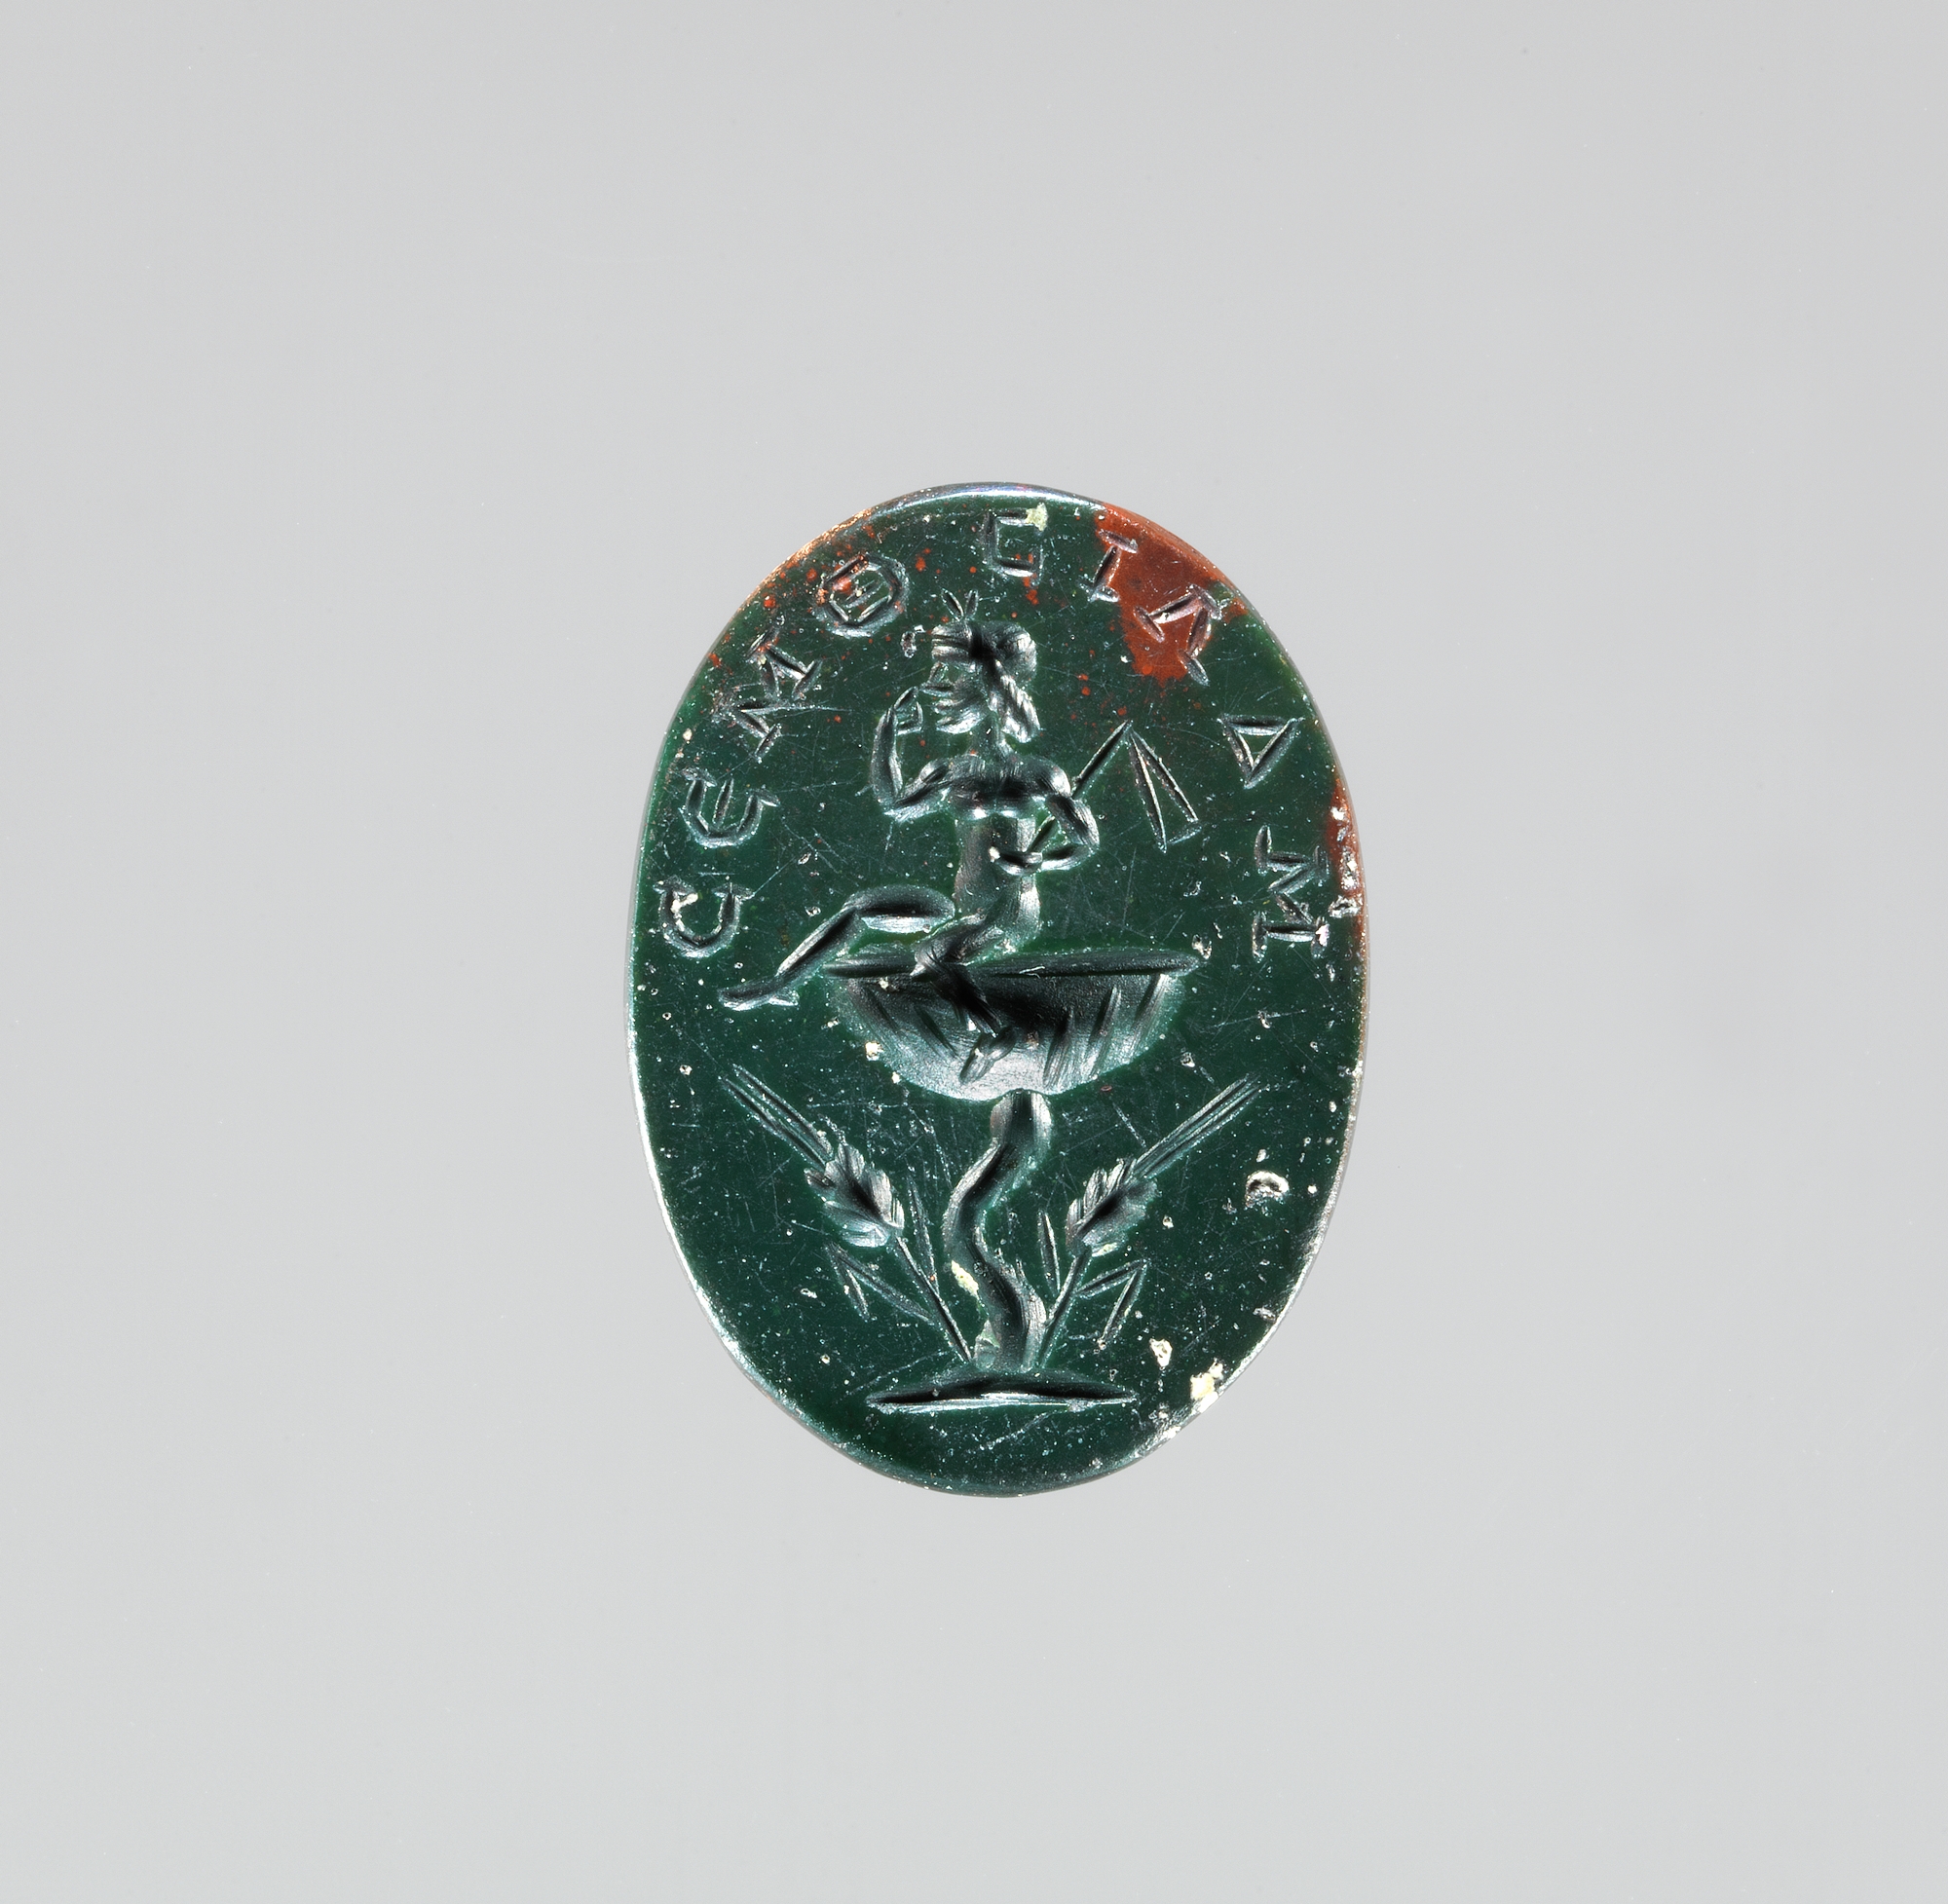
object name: intaglio, magical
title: Jasper intaglio: Harcoprates seated on a lotus flower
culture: roman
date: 101-300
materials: jasper